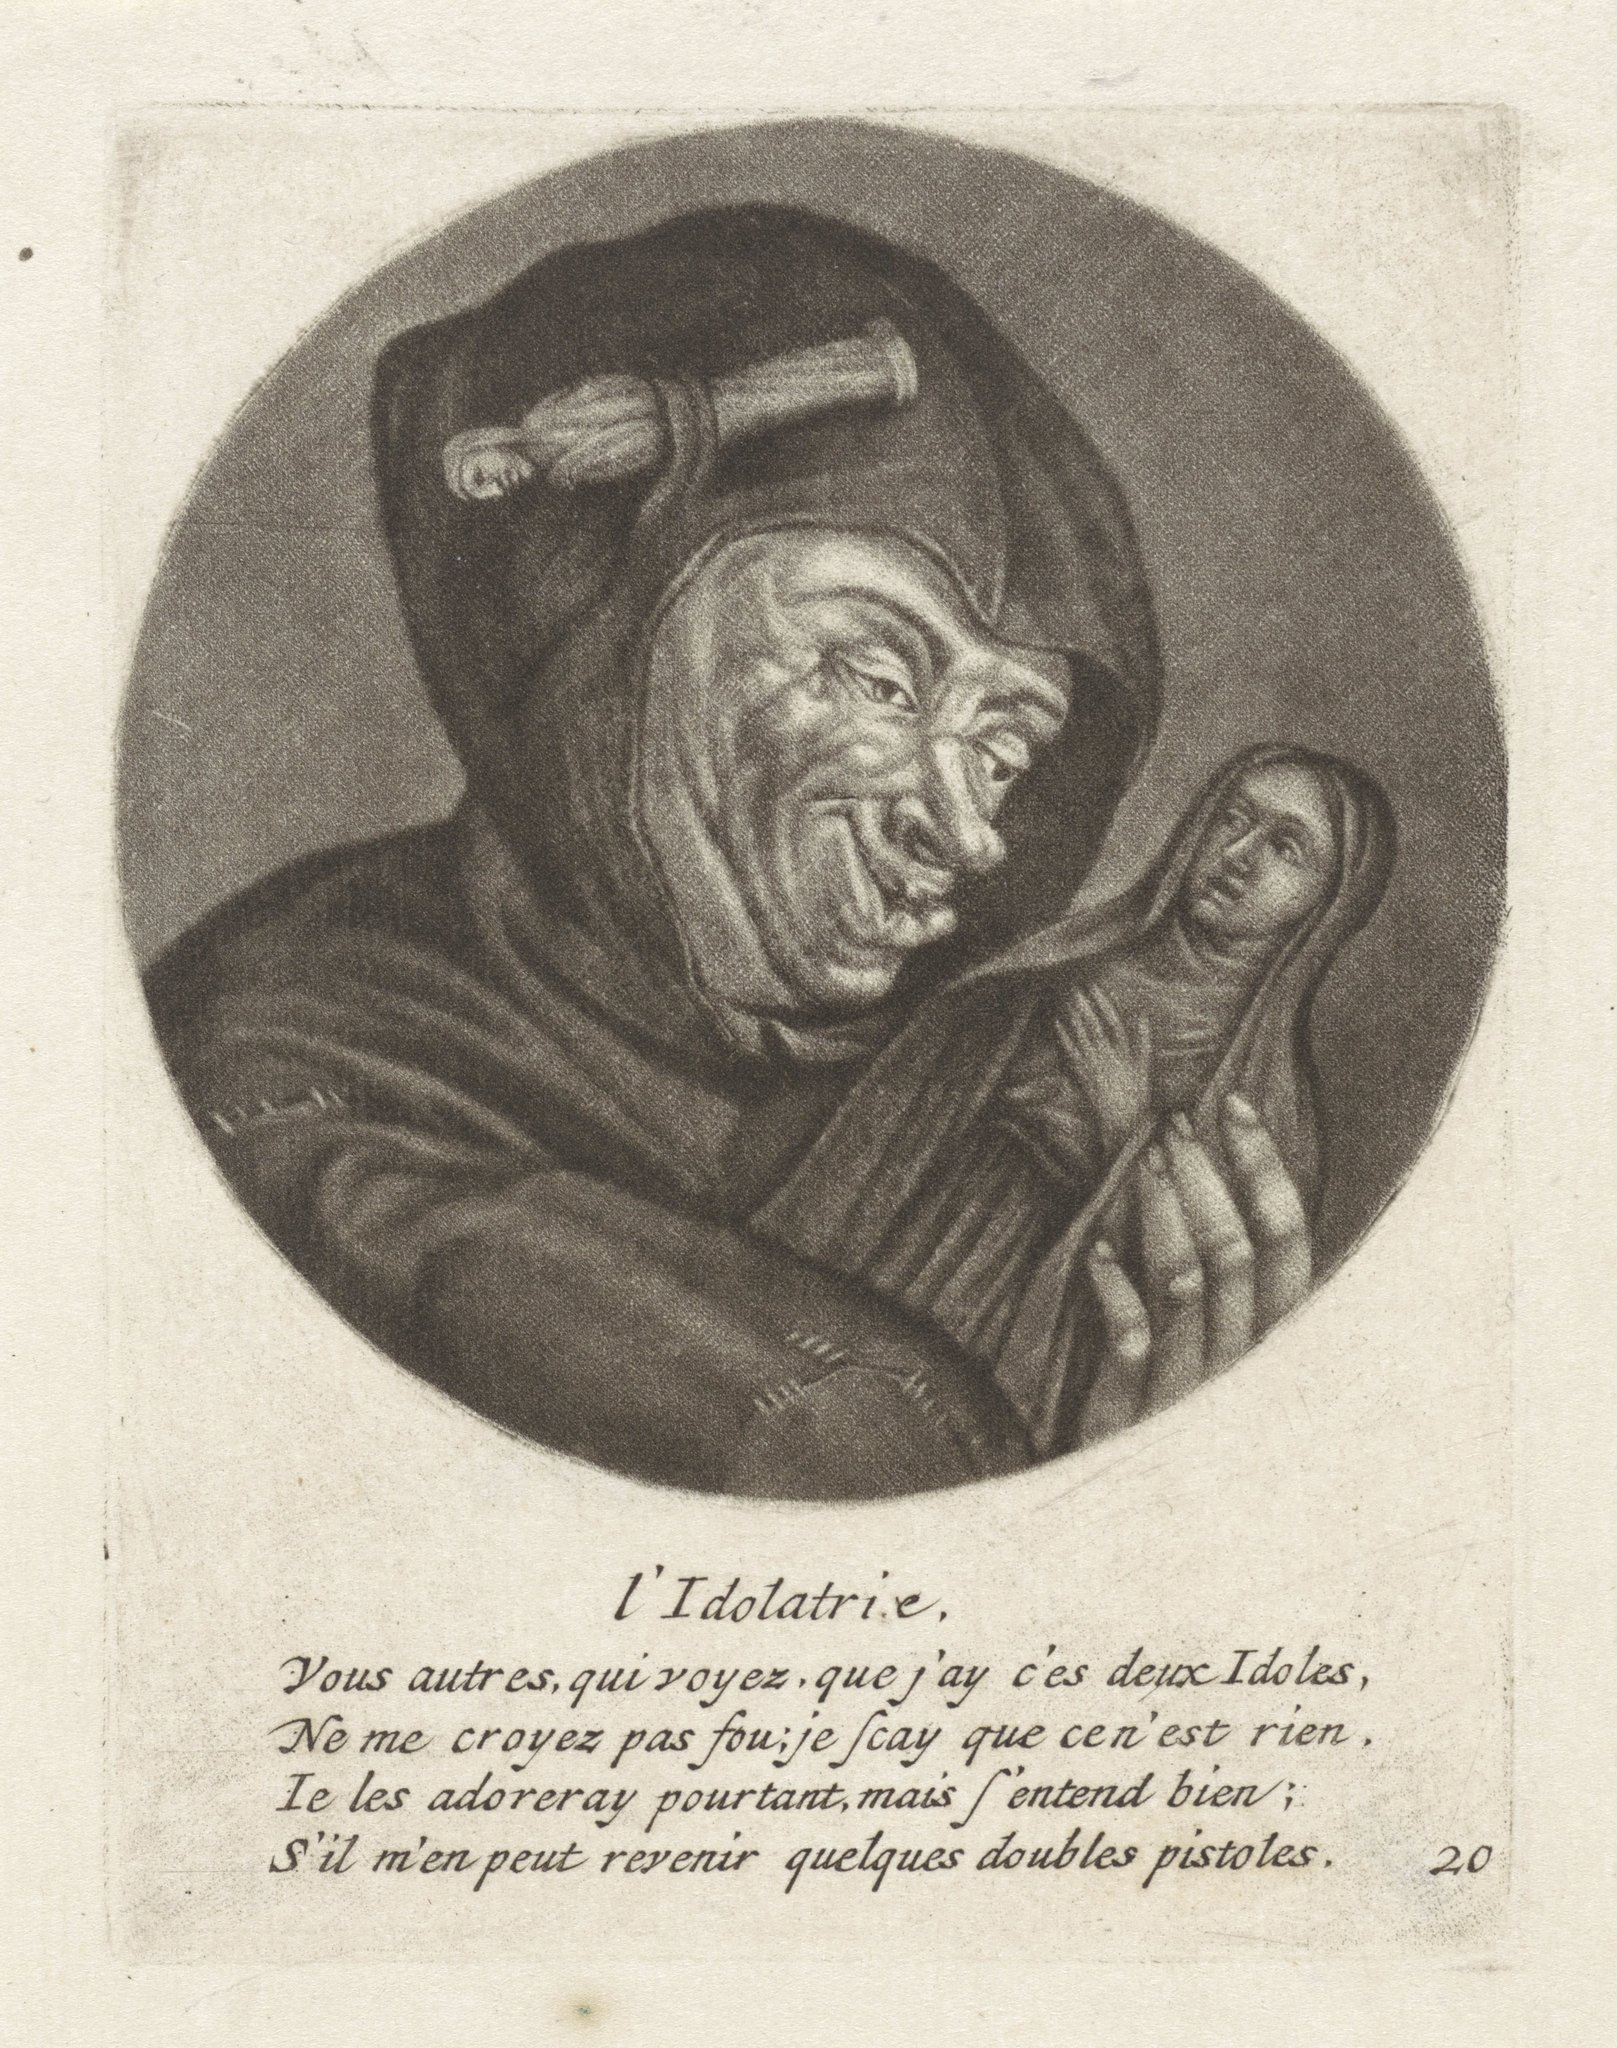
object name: print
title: Monnik met een beeld van Maria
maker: jacob gole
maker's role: print maker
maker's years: 1660-1724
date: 1670-1724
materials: paper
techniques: engraving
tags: monk(s), friar(s), mary devotion, political caricatures and satires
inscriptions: collector's mark: Lugt 2228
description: De prent verscheen in de bundel "Renversement de la Morale Chrétienne par les désordres du Monachisme". Volgens Wiebke Schmoldt (1997) verscheen deze bundel tussen 1693 en 1700.